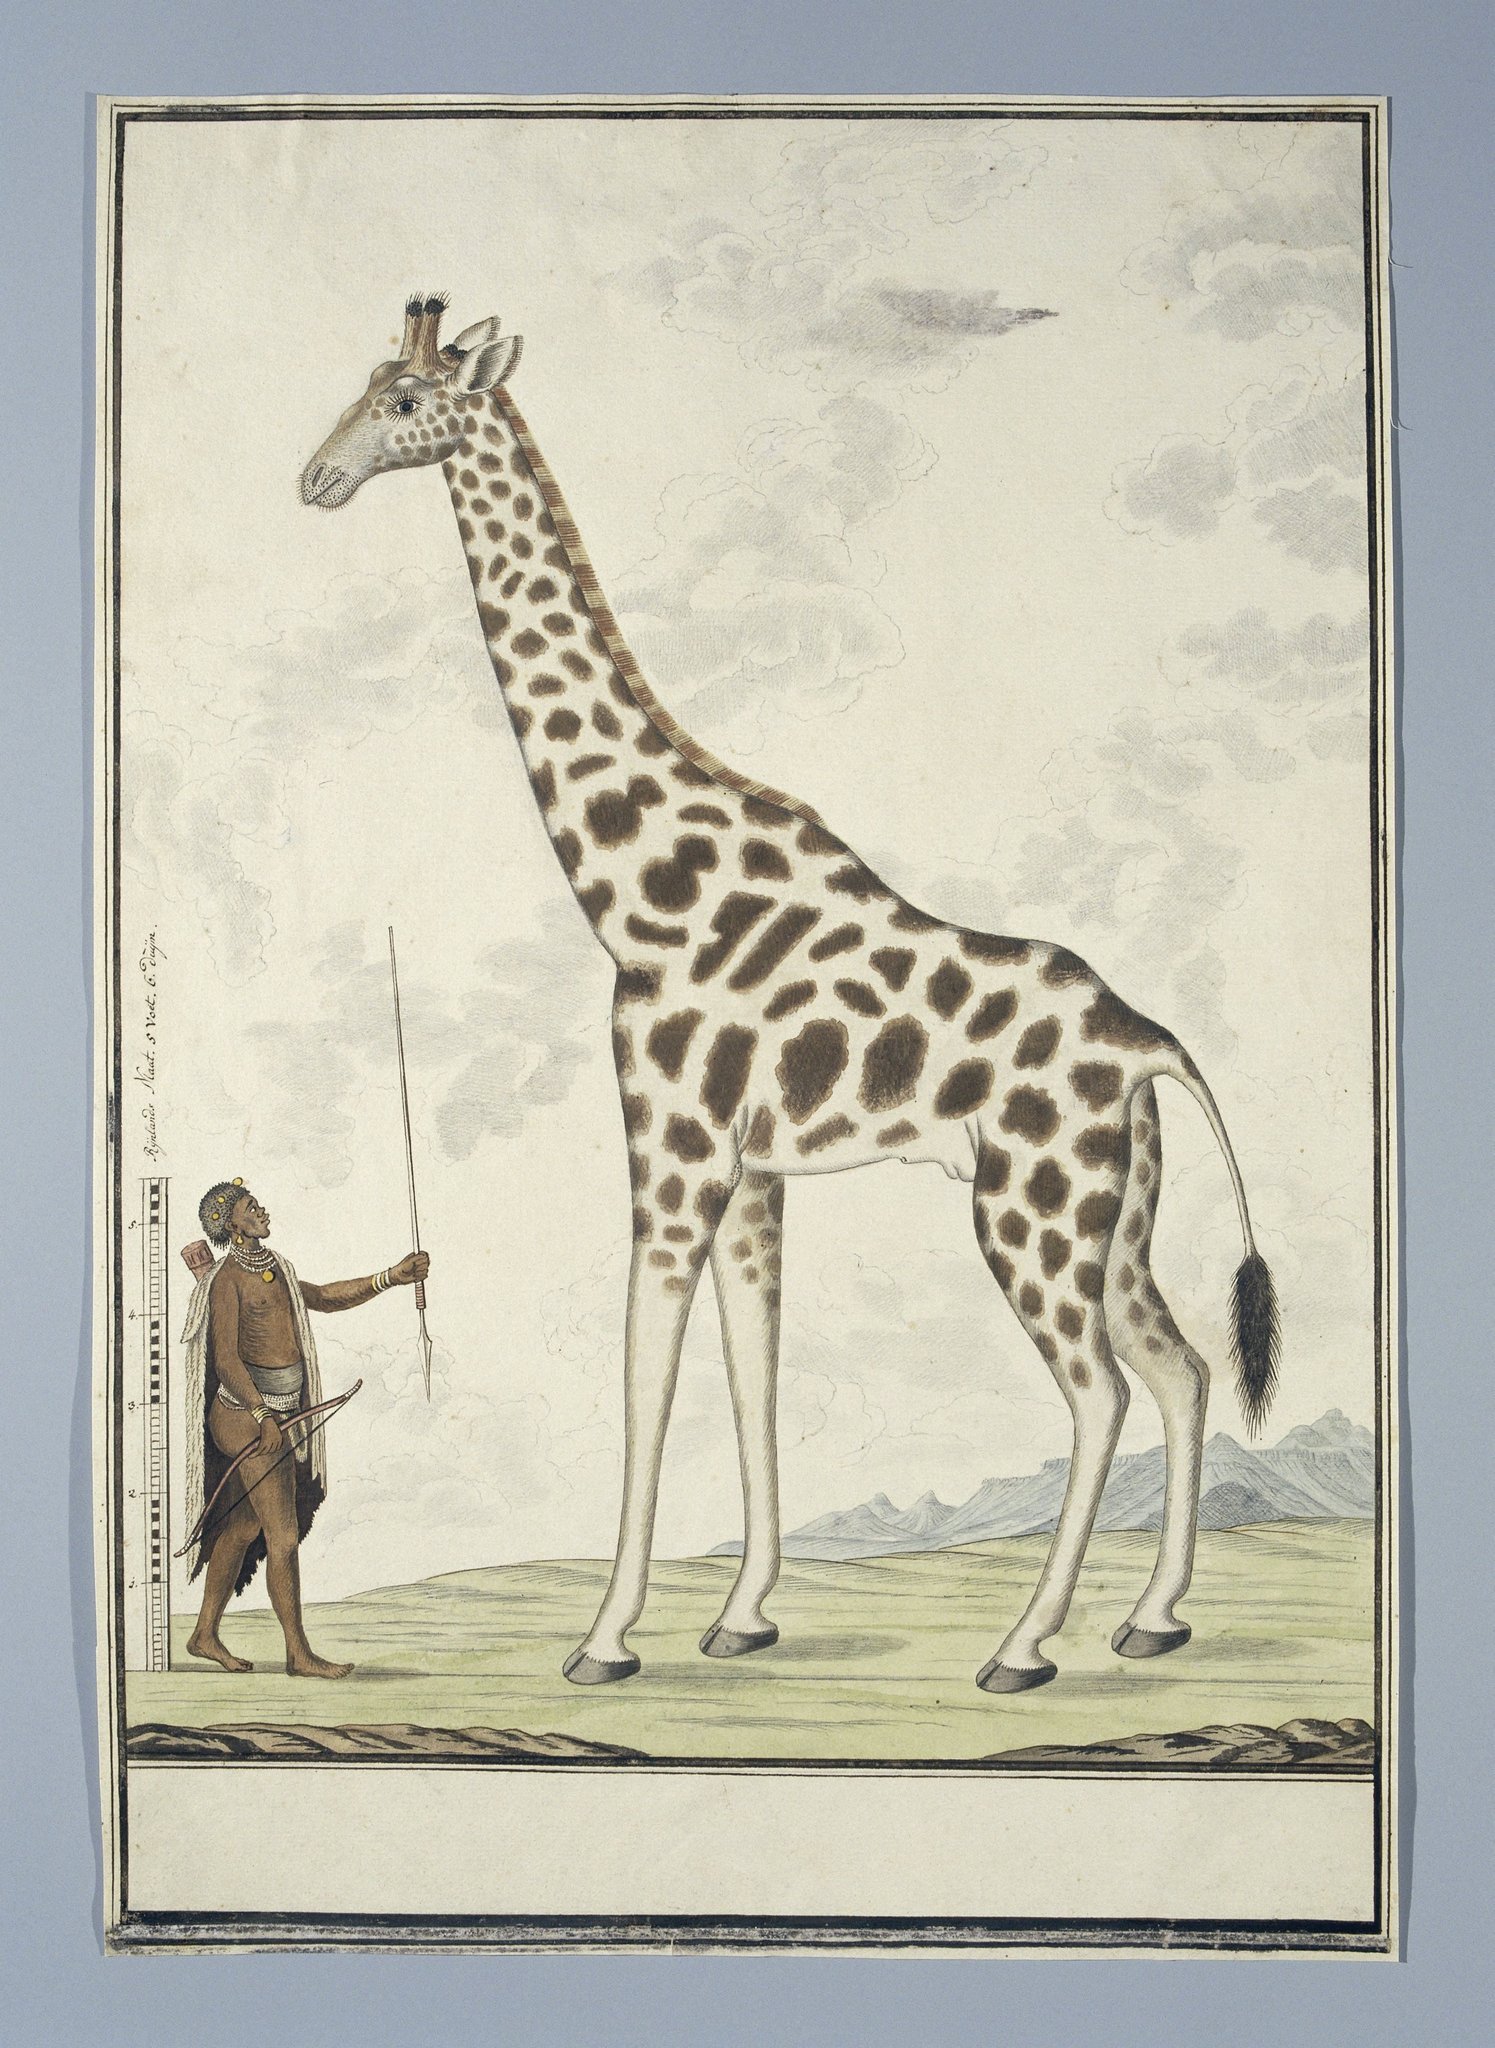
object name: album leaf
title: Giraffa camelopardalis (Giraffe)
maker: robert jacob gordon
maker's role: draughtsman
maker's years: 1743-1795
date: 1710-1779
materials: paint, ink, paper, pencil, watercolor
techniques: brush, pen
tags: hoofed animals: giraffe (+ skeleton of an animal), khoikhoi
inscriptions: annotation: ‘schaalverdeling, Rijnlandse Maat. 5 Voet. 6 Duijm.’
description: Giraf (Giraffa camelopardalis), met schaalverdeling van de Khoikhoi in Rijnlandse maat, de assegaai als meetlat omhooggehouden.